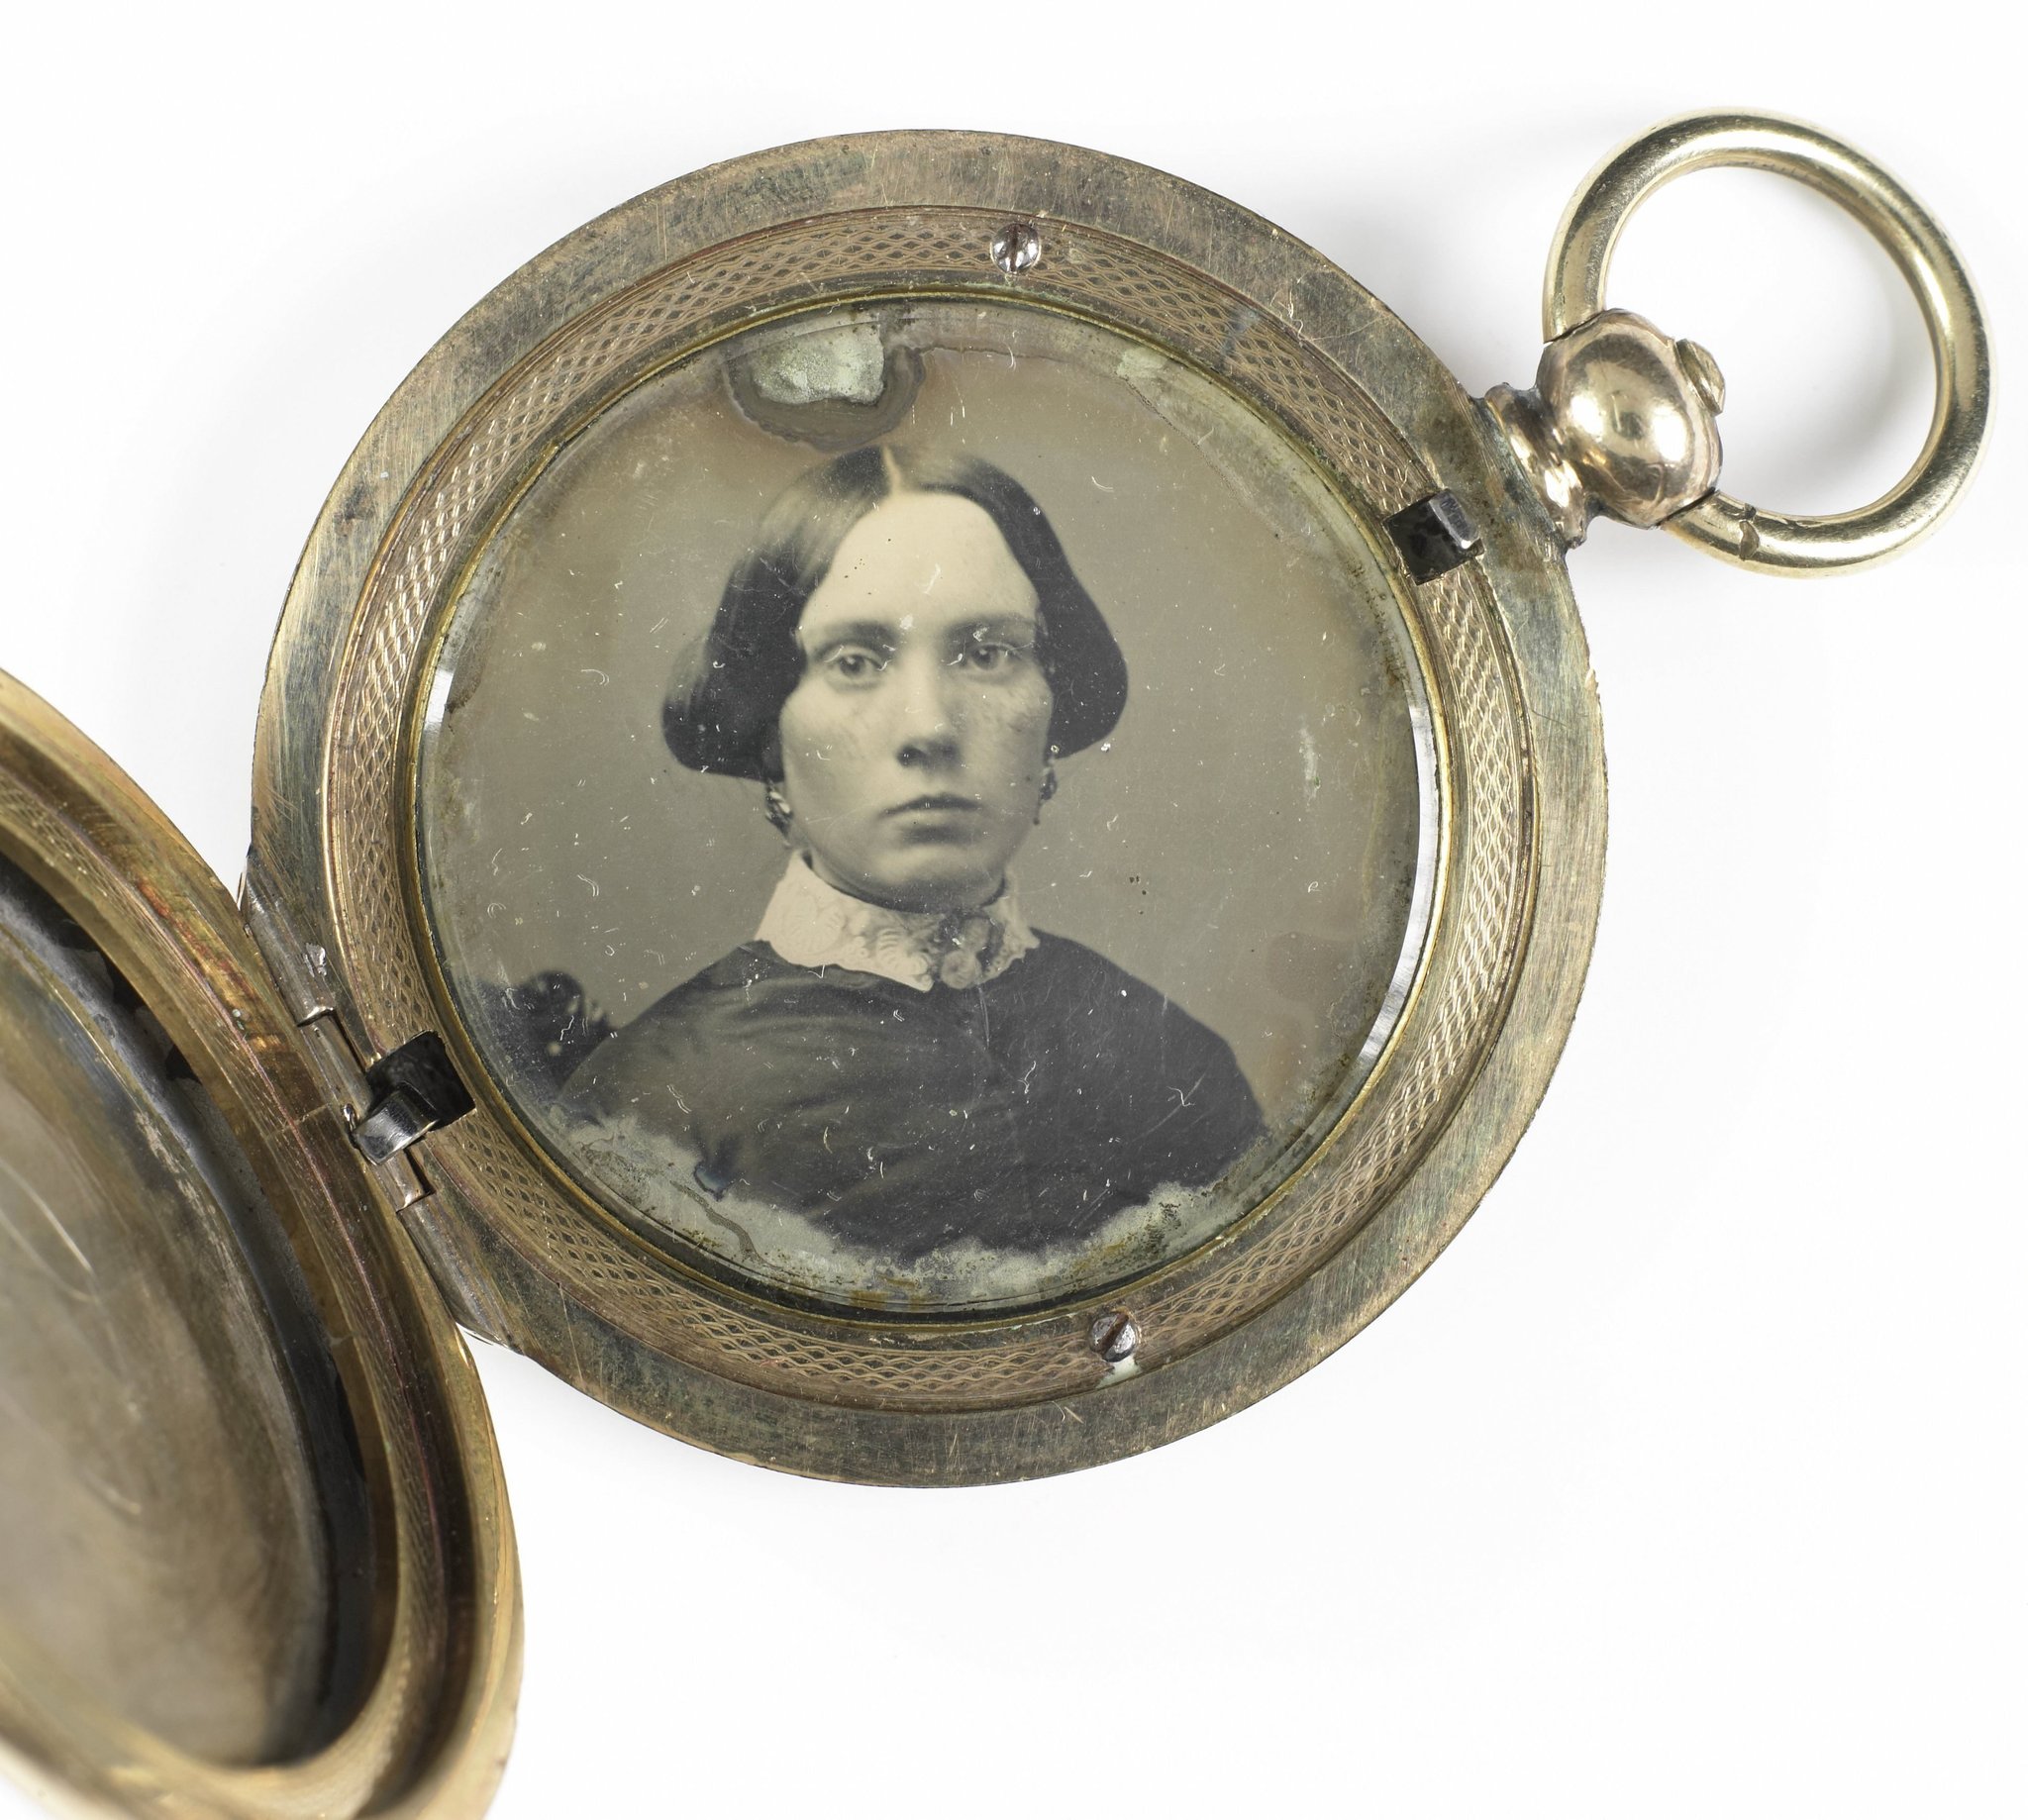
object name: locket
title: Portret van een onbekende jonge vrouw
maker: Anonymous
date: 1840-1860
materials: copper, glass, metal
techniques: daguerreotype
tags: adolescent, young woman, maiden, historical persons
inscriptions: number: ‘28’